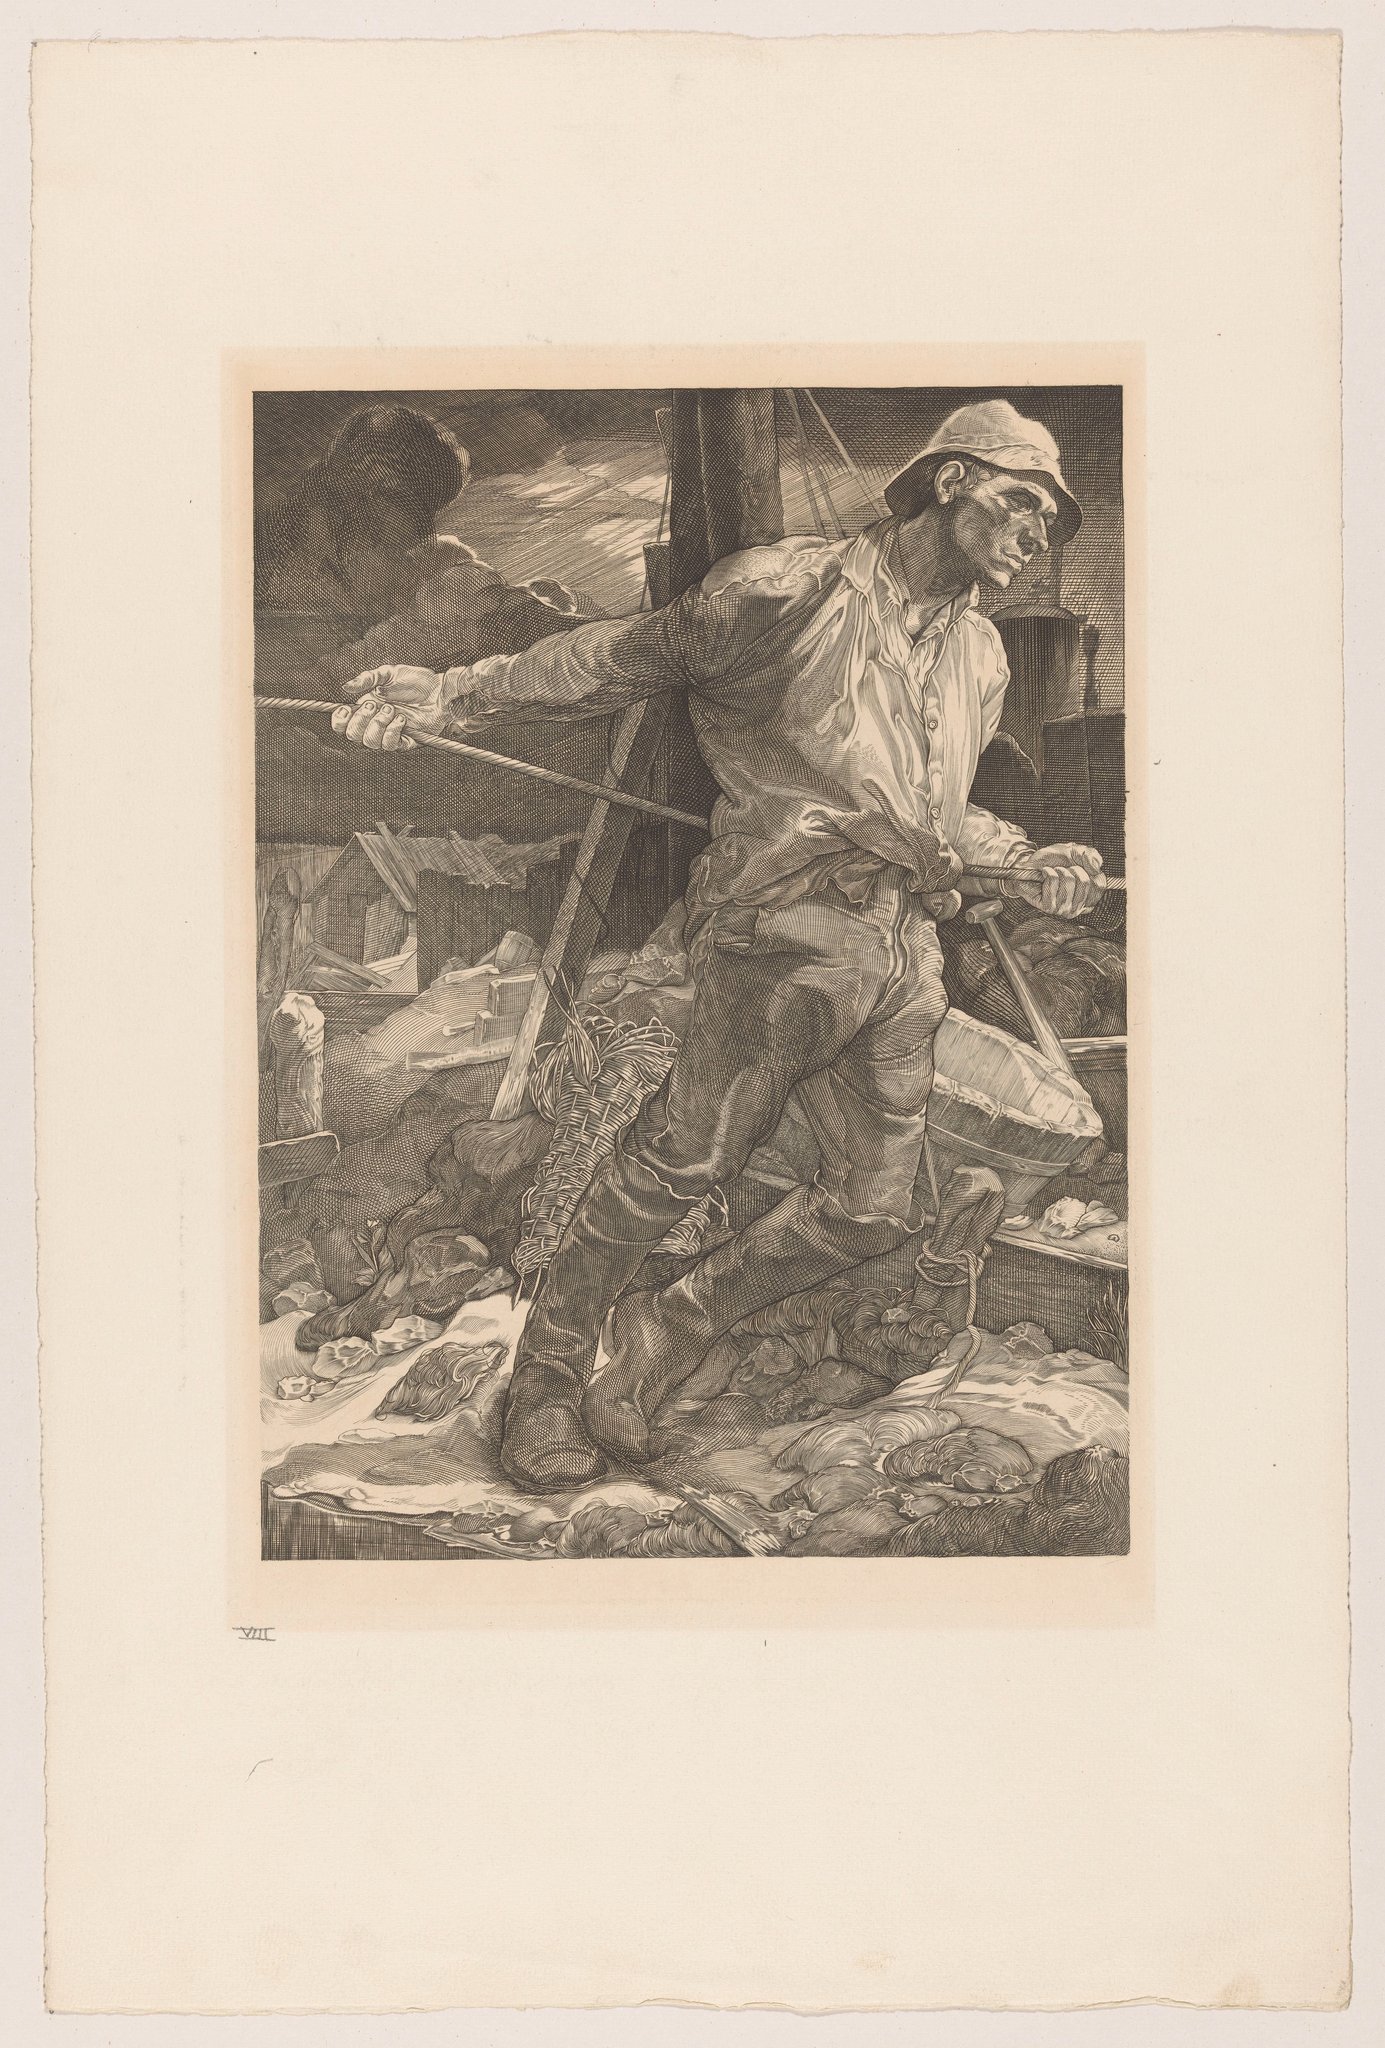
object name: print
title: Arbeider die een touw laat vieren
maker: johannes josephus aarts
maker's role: draughtsman, print maker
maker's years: 1871-1934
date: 1881-1934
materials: paper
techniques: engraving, intaglio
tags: working class, labourers, tools, aids, implements ~ crafts and industries: rope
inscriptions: collector's mark: Lugt 2166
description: Een arbeider die een hoed en laarzen draagt, laat een touw vieren. Op de achtergrond onder meer een schep, een kuip, een hek, een hut en een machine.